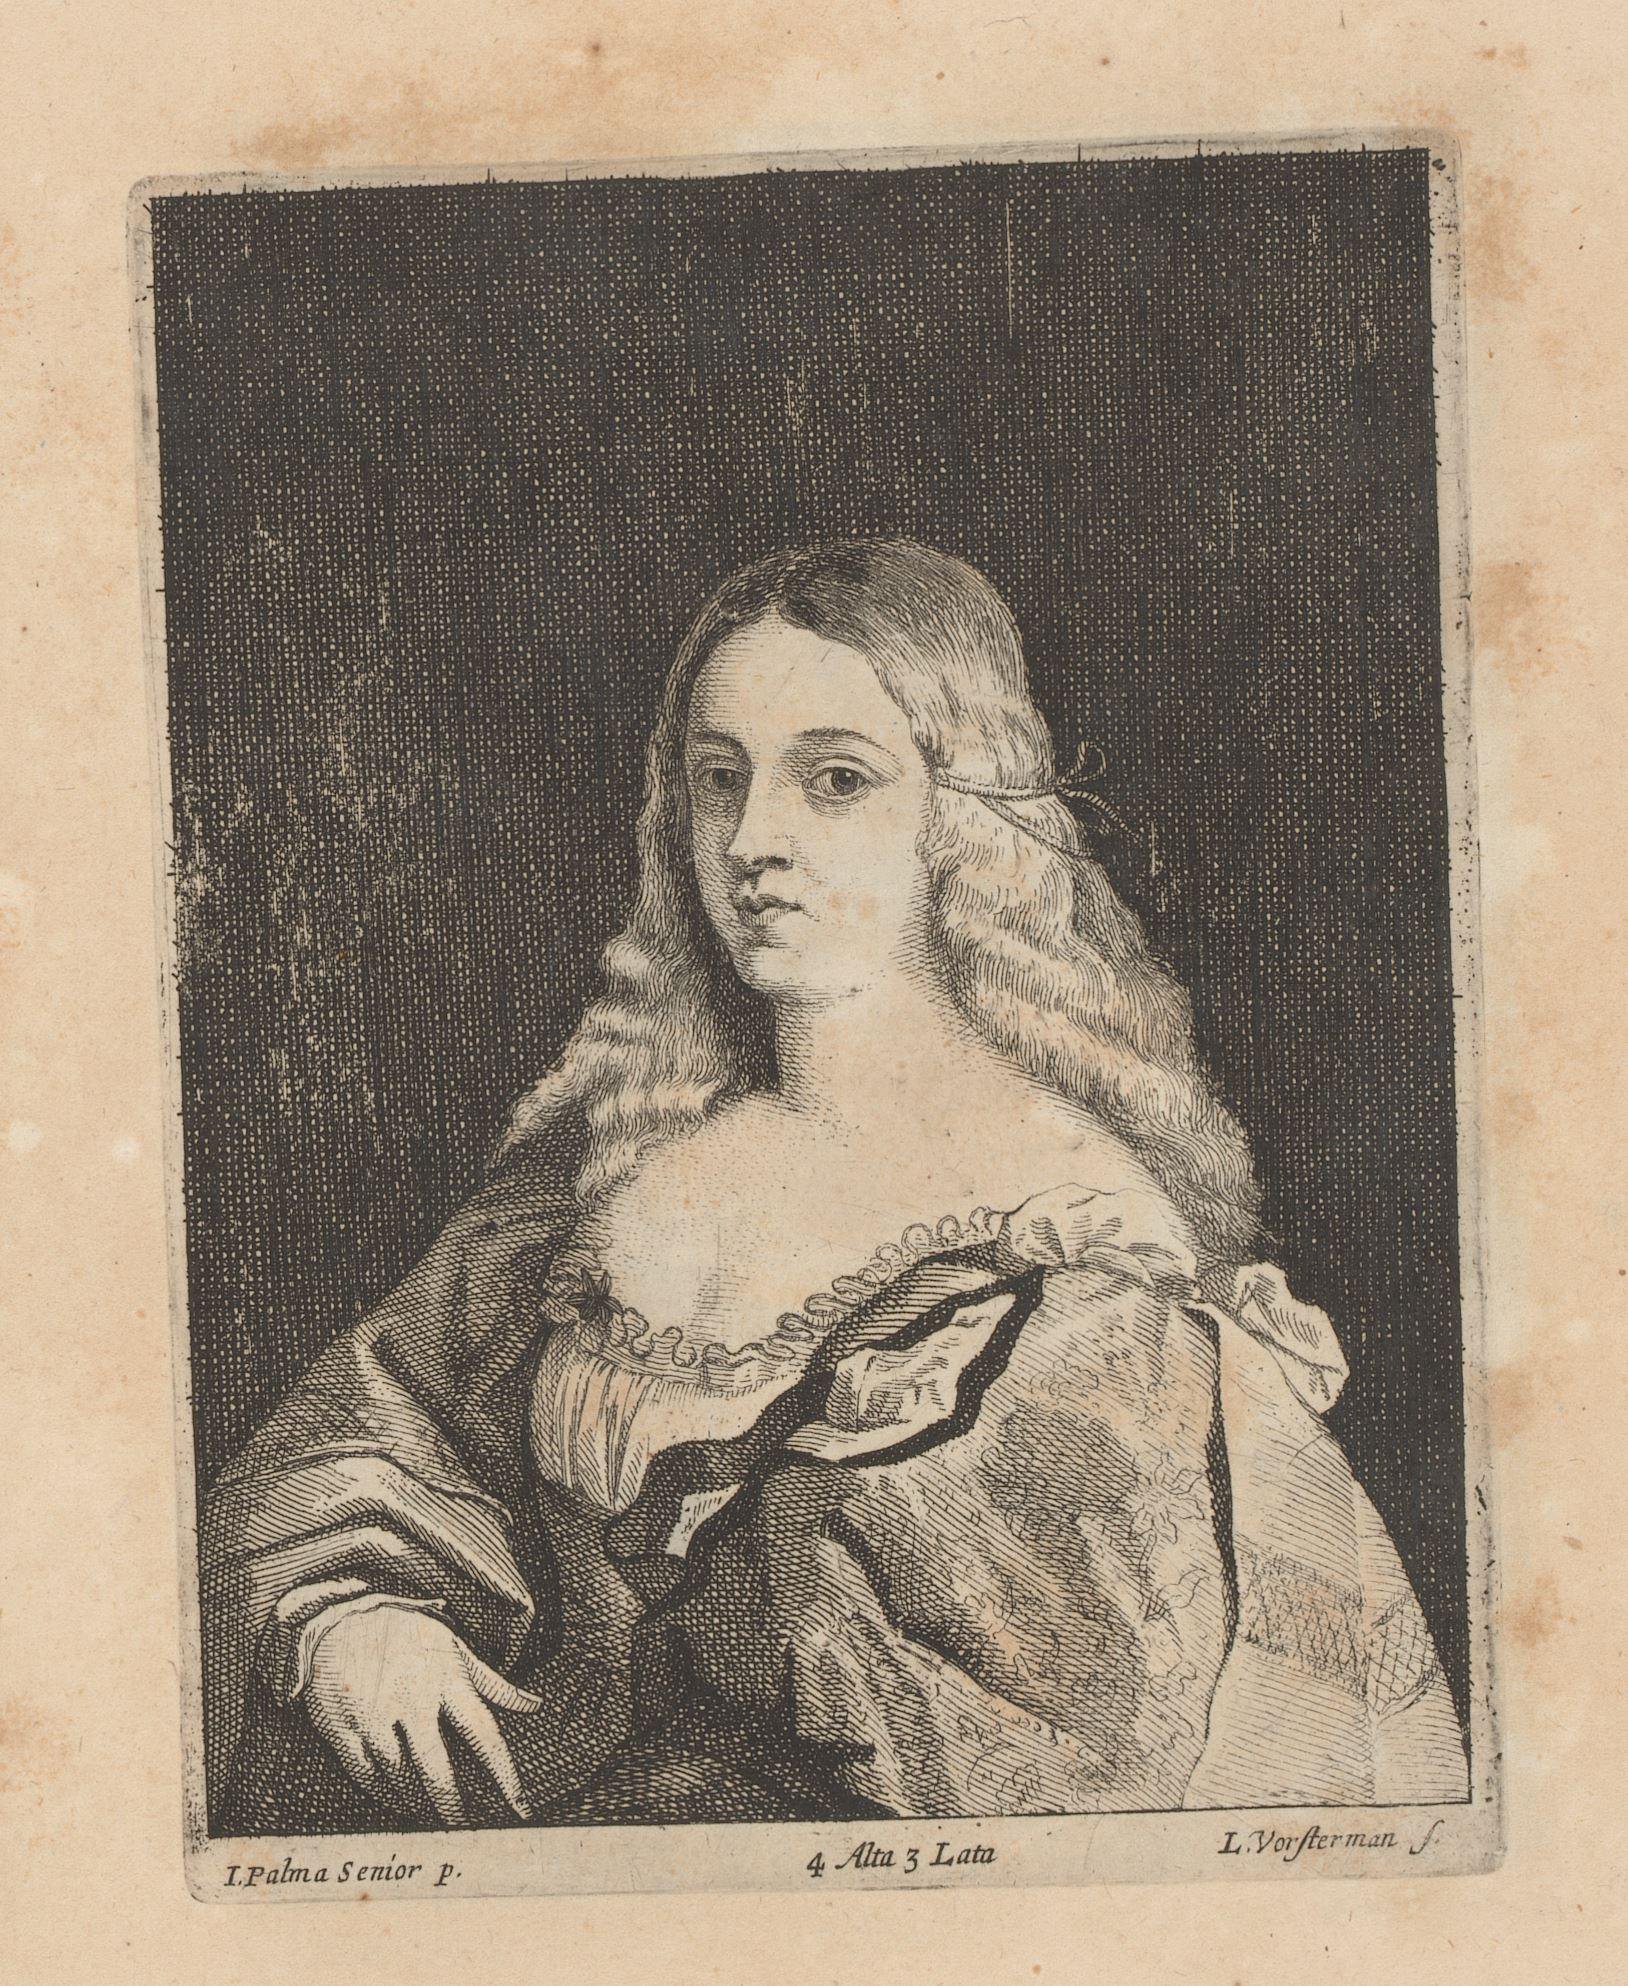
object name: album leaf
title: Portret van een jonge vrouw (Violante)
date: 1660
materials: paper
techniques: etching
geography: brussels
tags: anonymous historical person portrayed alone - bb - woman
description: De prent is vervaardigd naar het schilderij van Titiaan dat zich in de collectie van het Kunsthistorisches Museum te Wenen bevindt (inventarisnummer GG_65). David Teniers heeft waarschijnlijk van alle schilderijen uit de collectie van Leopold Willem van Oostenrijk een olieverfstudie op doek of paneel vervaardigd (zgn. pasticcio), die als voorbeeld voor de prentmakers diende. Het is niet altijd duidelijk of de pasticci door hem zijn gemaakt of door zijn atelier. Niet alle pasticci zijn overgeleverd.